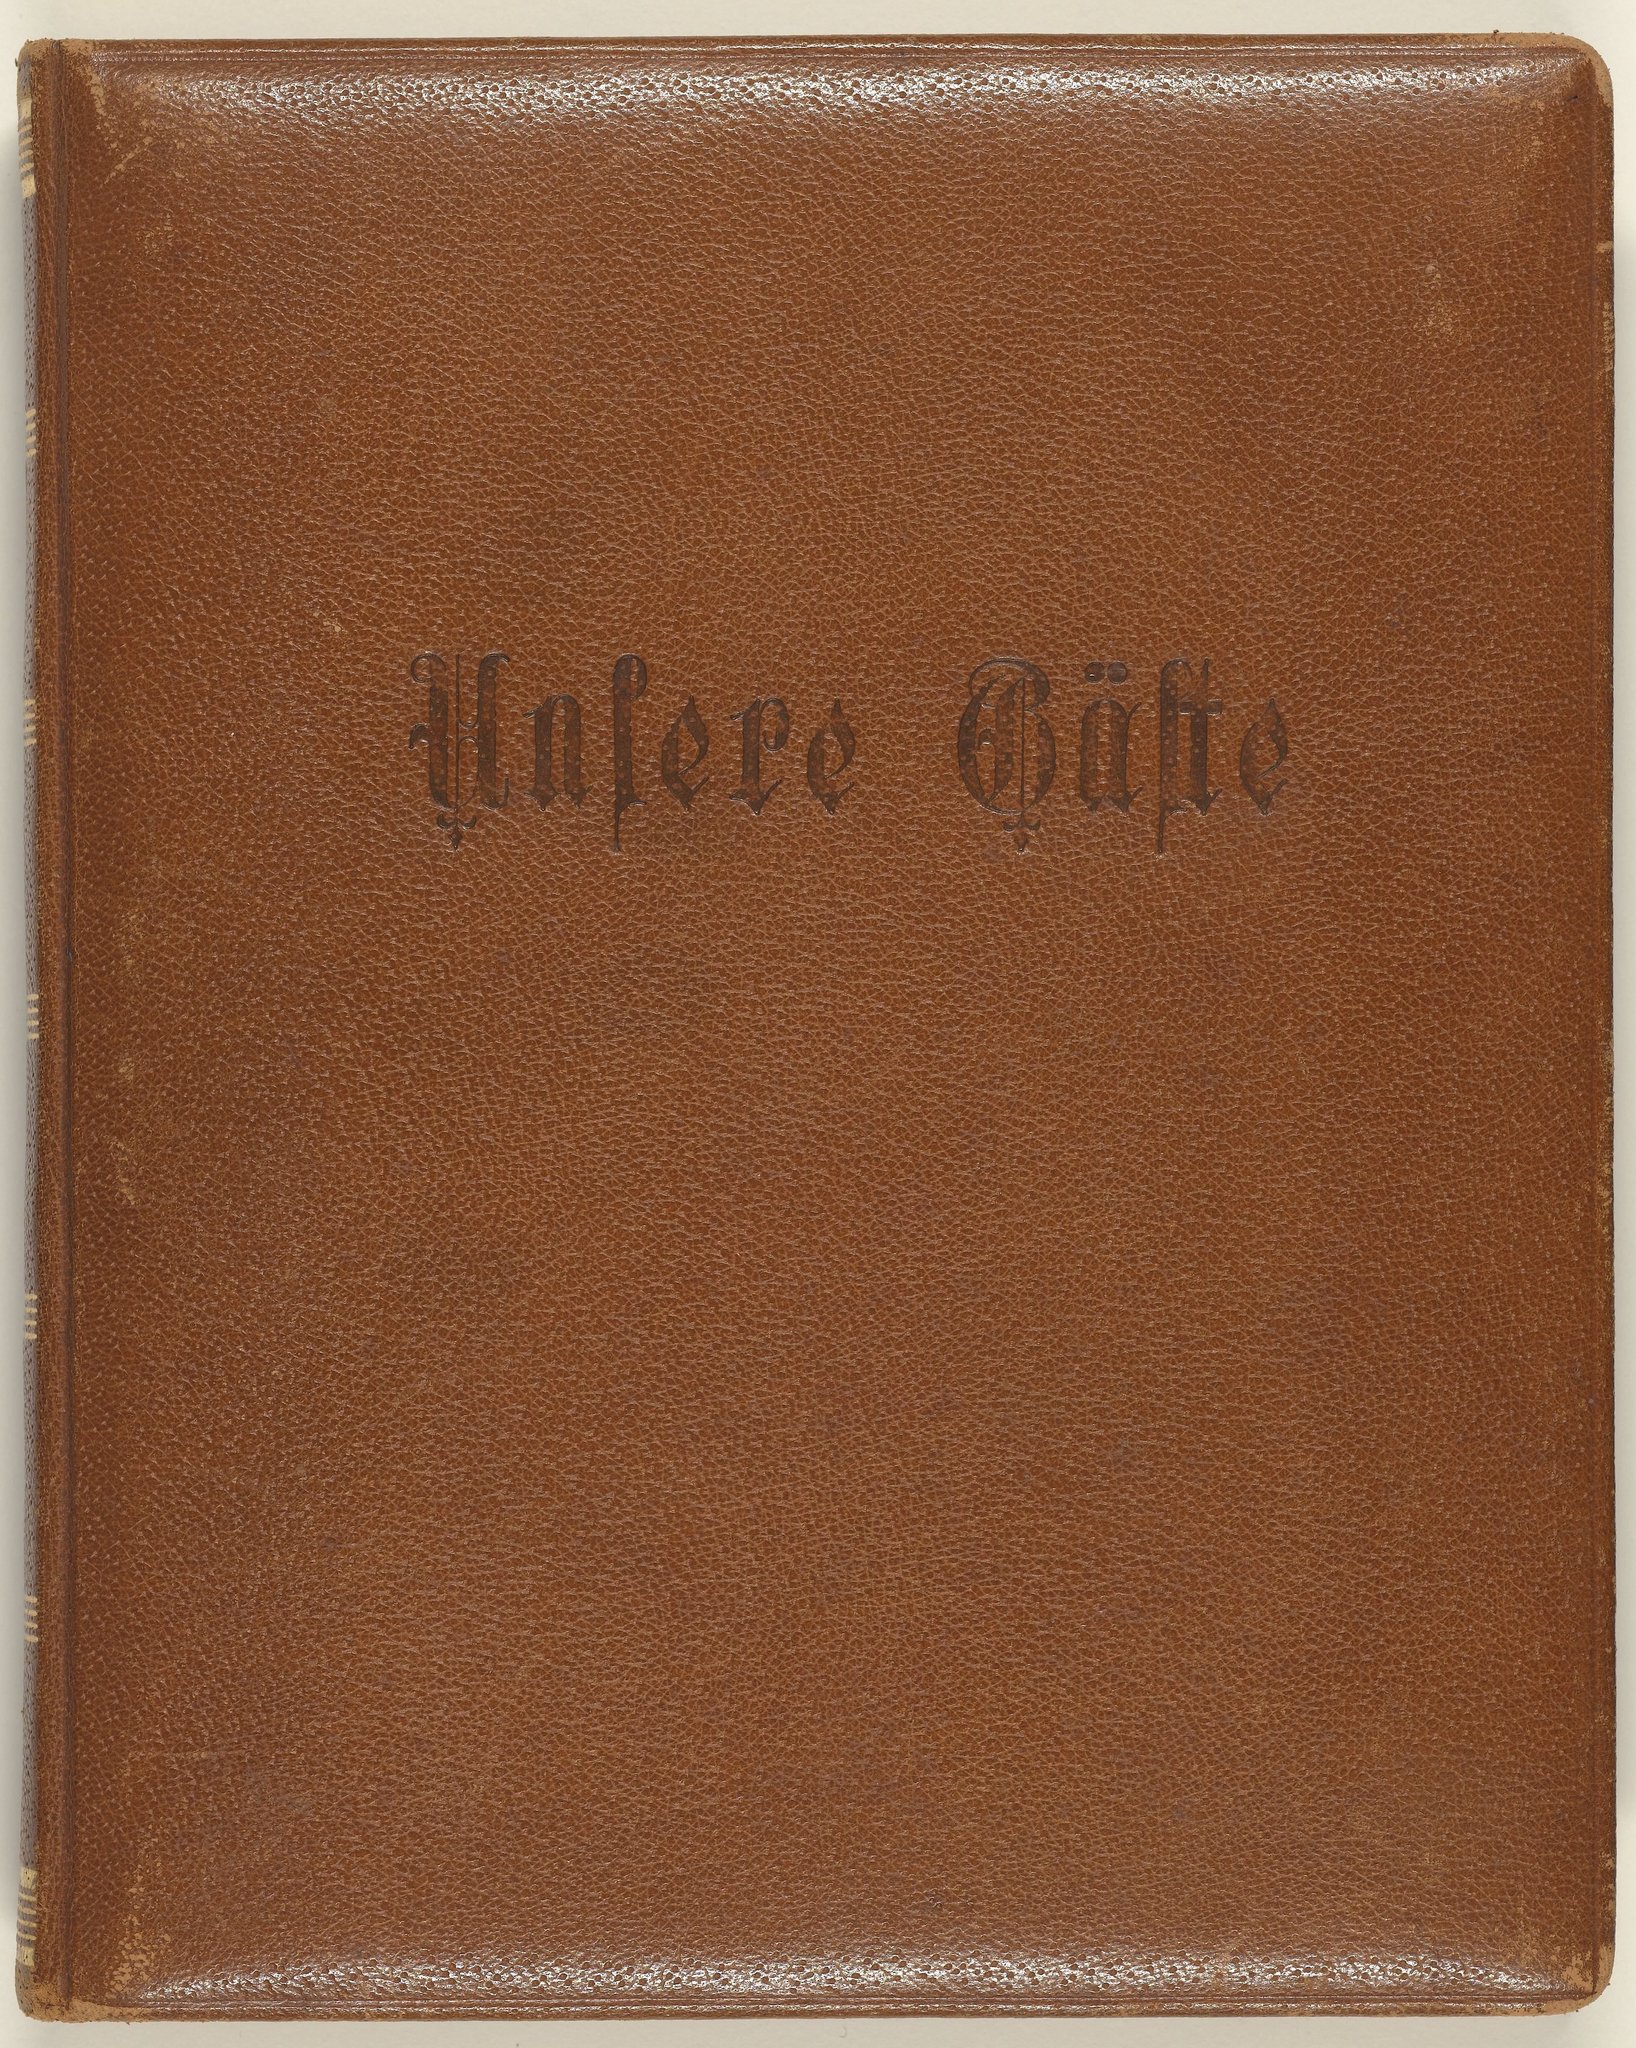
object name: photograph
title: Zandvoort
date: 1900-1905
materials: photographic support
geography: zandvoort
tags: zandvoort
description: Zandvoort was toen een badplaats met internationale allure. Veel hotels droegen Duitse namen, de gegoede Duitse burgerij en de adel kwamen er graag, vooral na de opening van de spoorlijn met Haarlem in 1881. In 1907 stonden in Zandvoort al 9 hotels en 23 pensions. Er kwamen rond de 9000 badgasten per jaar. Vanaf 1905 kwamen er meer middenstanders en 'gewone' mensen naar Zandvoort, het begin van het massatoerisme.